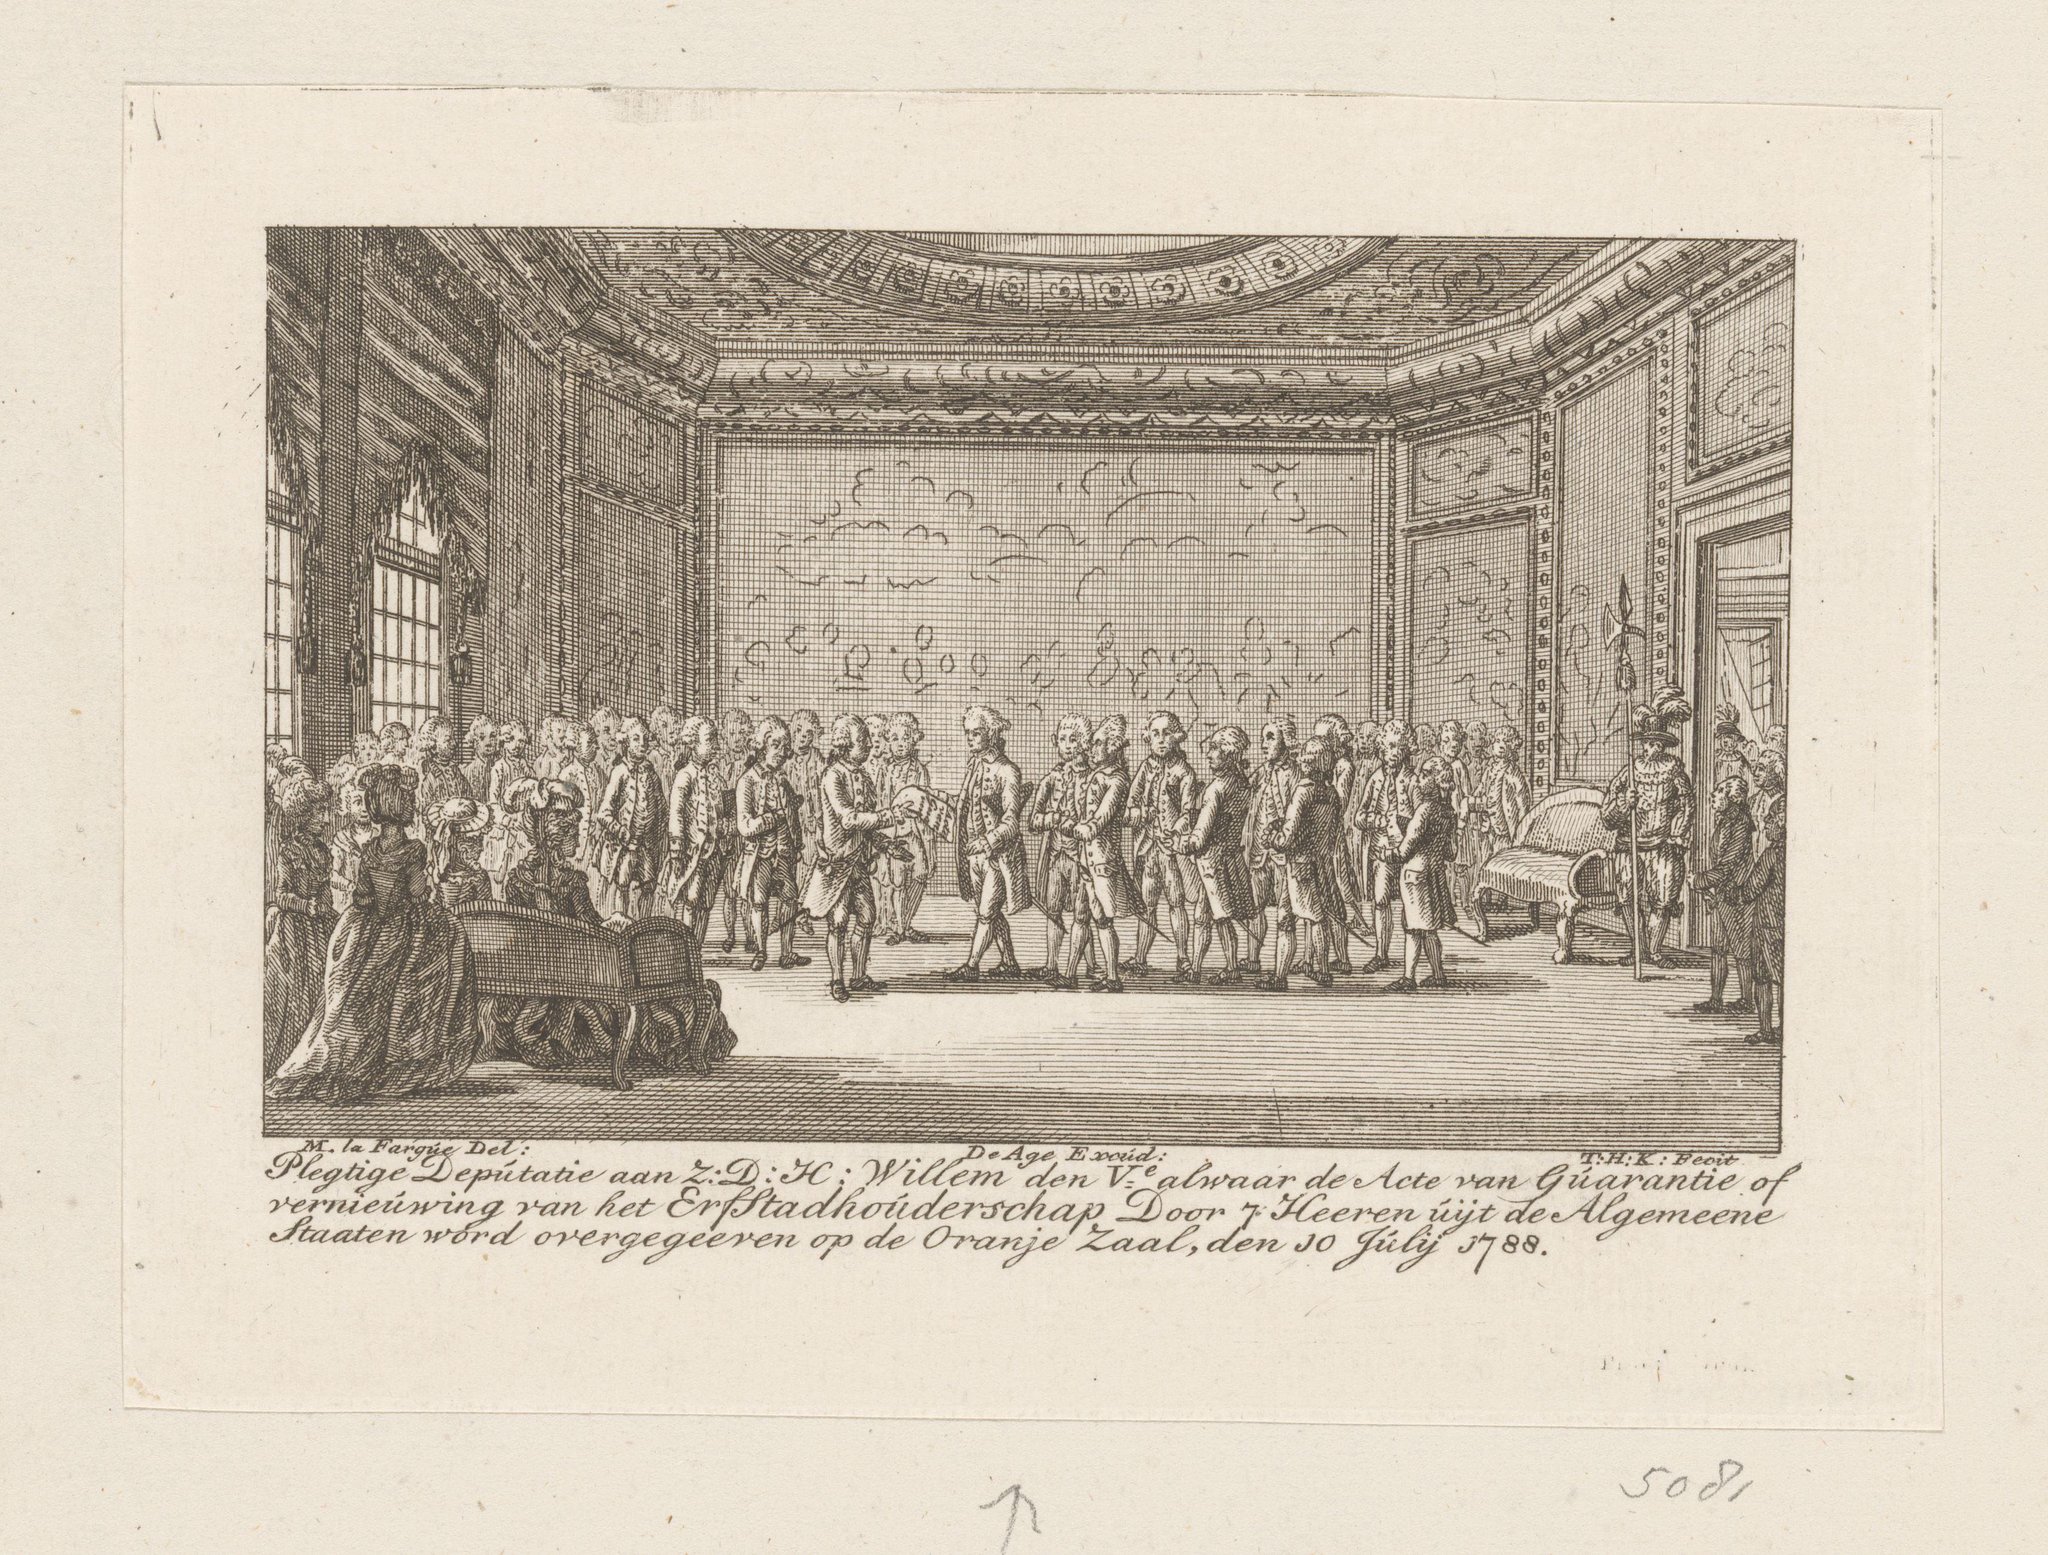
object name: print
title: Plegtige Deputatie aan Z:D:H: Willem den Ve alwaar de Acte van Guarantie of vernieuwing van het Erfstandhouderschap Door 7 heeren uijt de Algemeende Staaten word overgegeeven op de Oranje Zaal, den 10 July 1788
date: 1788-1789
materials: paper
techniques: etching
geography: the hague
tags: the hague, william v (prince of orange), ceremonial celebration of installation of a ruler, interior of the house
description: Presentatie van de Acte van Garantie door leden van de Staten-Generaal aan stadhouder Willem V, 10 juli 1788.